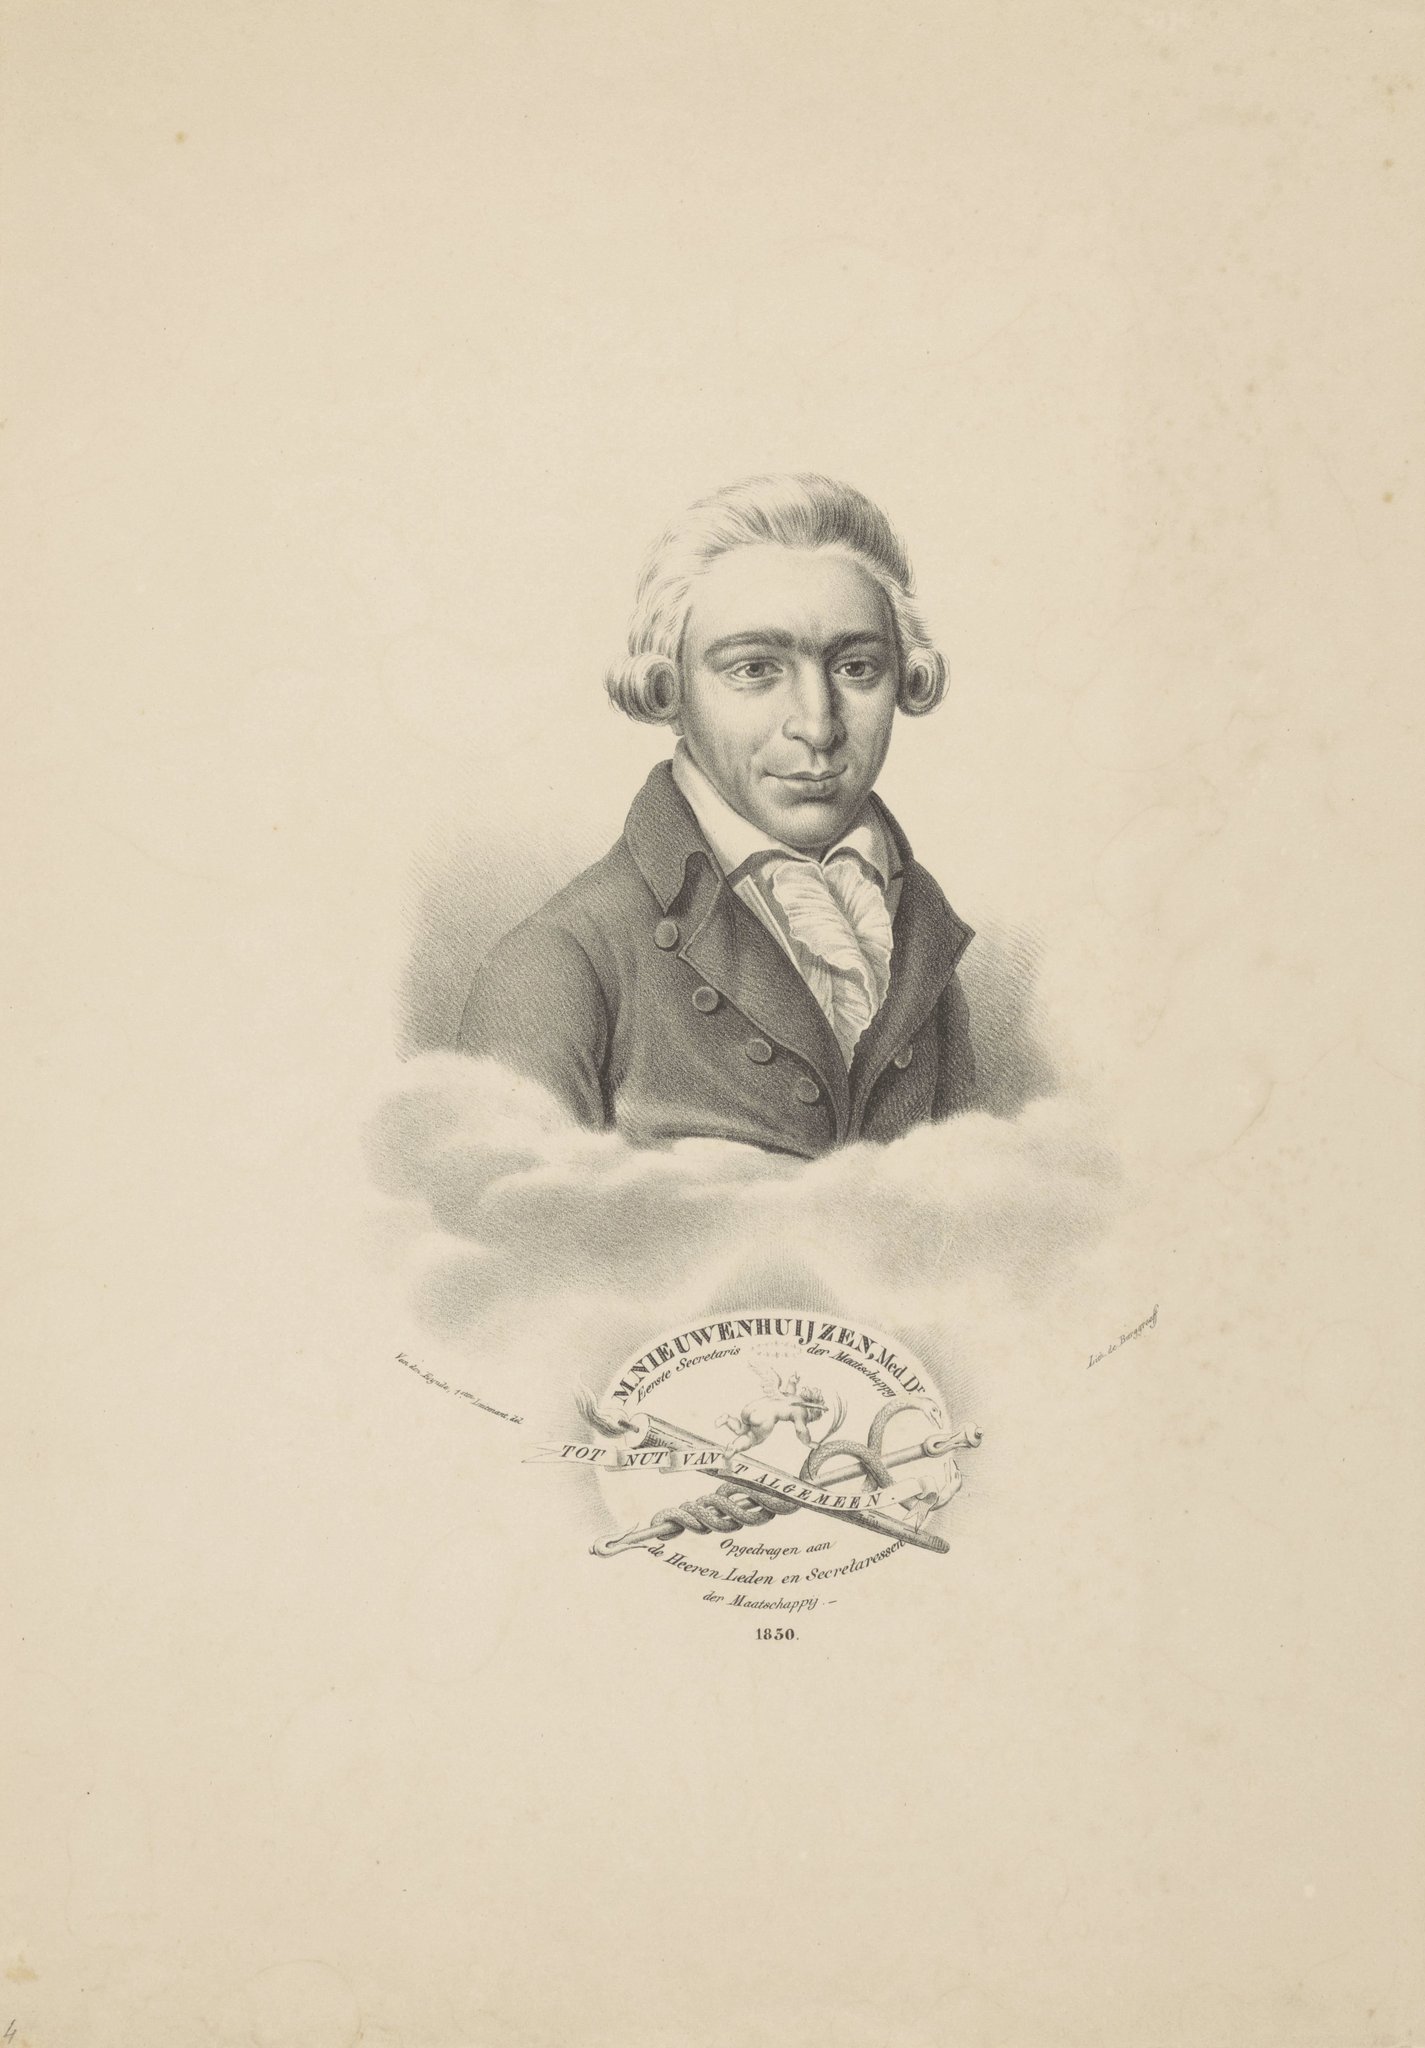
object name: print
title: Portret van M. Nieuwenhuyzen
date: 1830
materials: paper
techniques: lithograph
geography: brussels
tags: torch, caduceus (staff with two snakes, attribute of mercury), historical persons (+ (full) bust portrait)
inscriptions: collector's mark: Lugt 2228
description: De geportretteerde is afgebeeld in een wolkenpartij. Hij draagt een pruik. Onder het portret een vignet met daarin een fakkel, een mercuriusstaf en een putto. Daarin een banier met de opdracht: de heren leden secretaressen der Maatschappij tot Nut van het Algemeen.